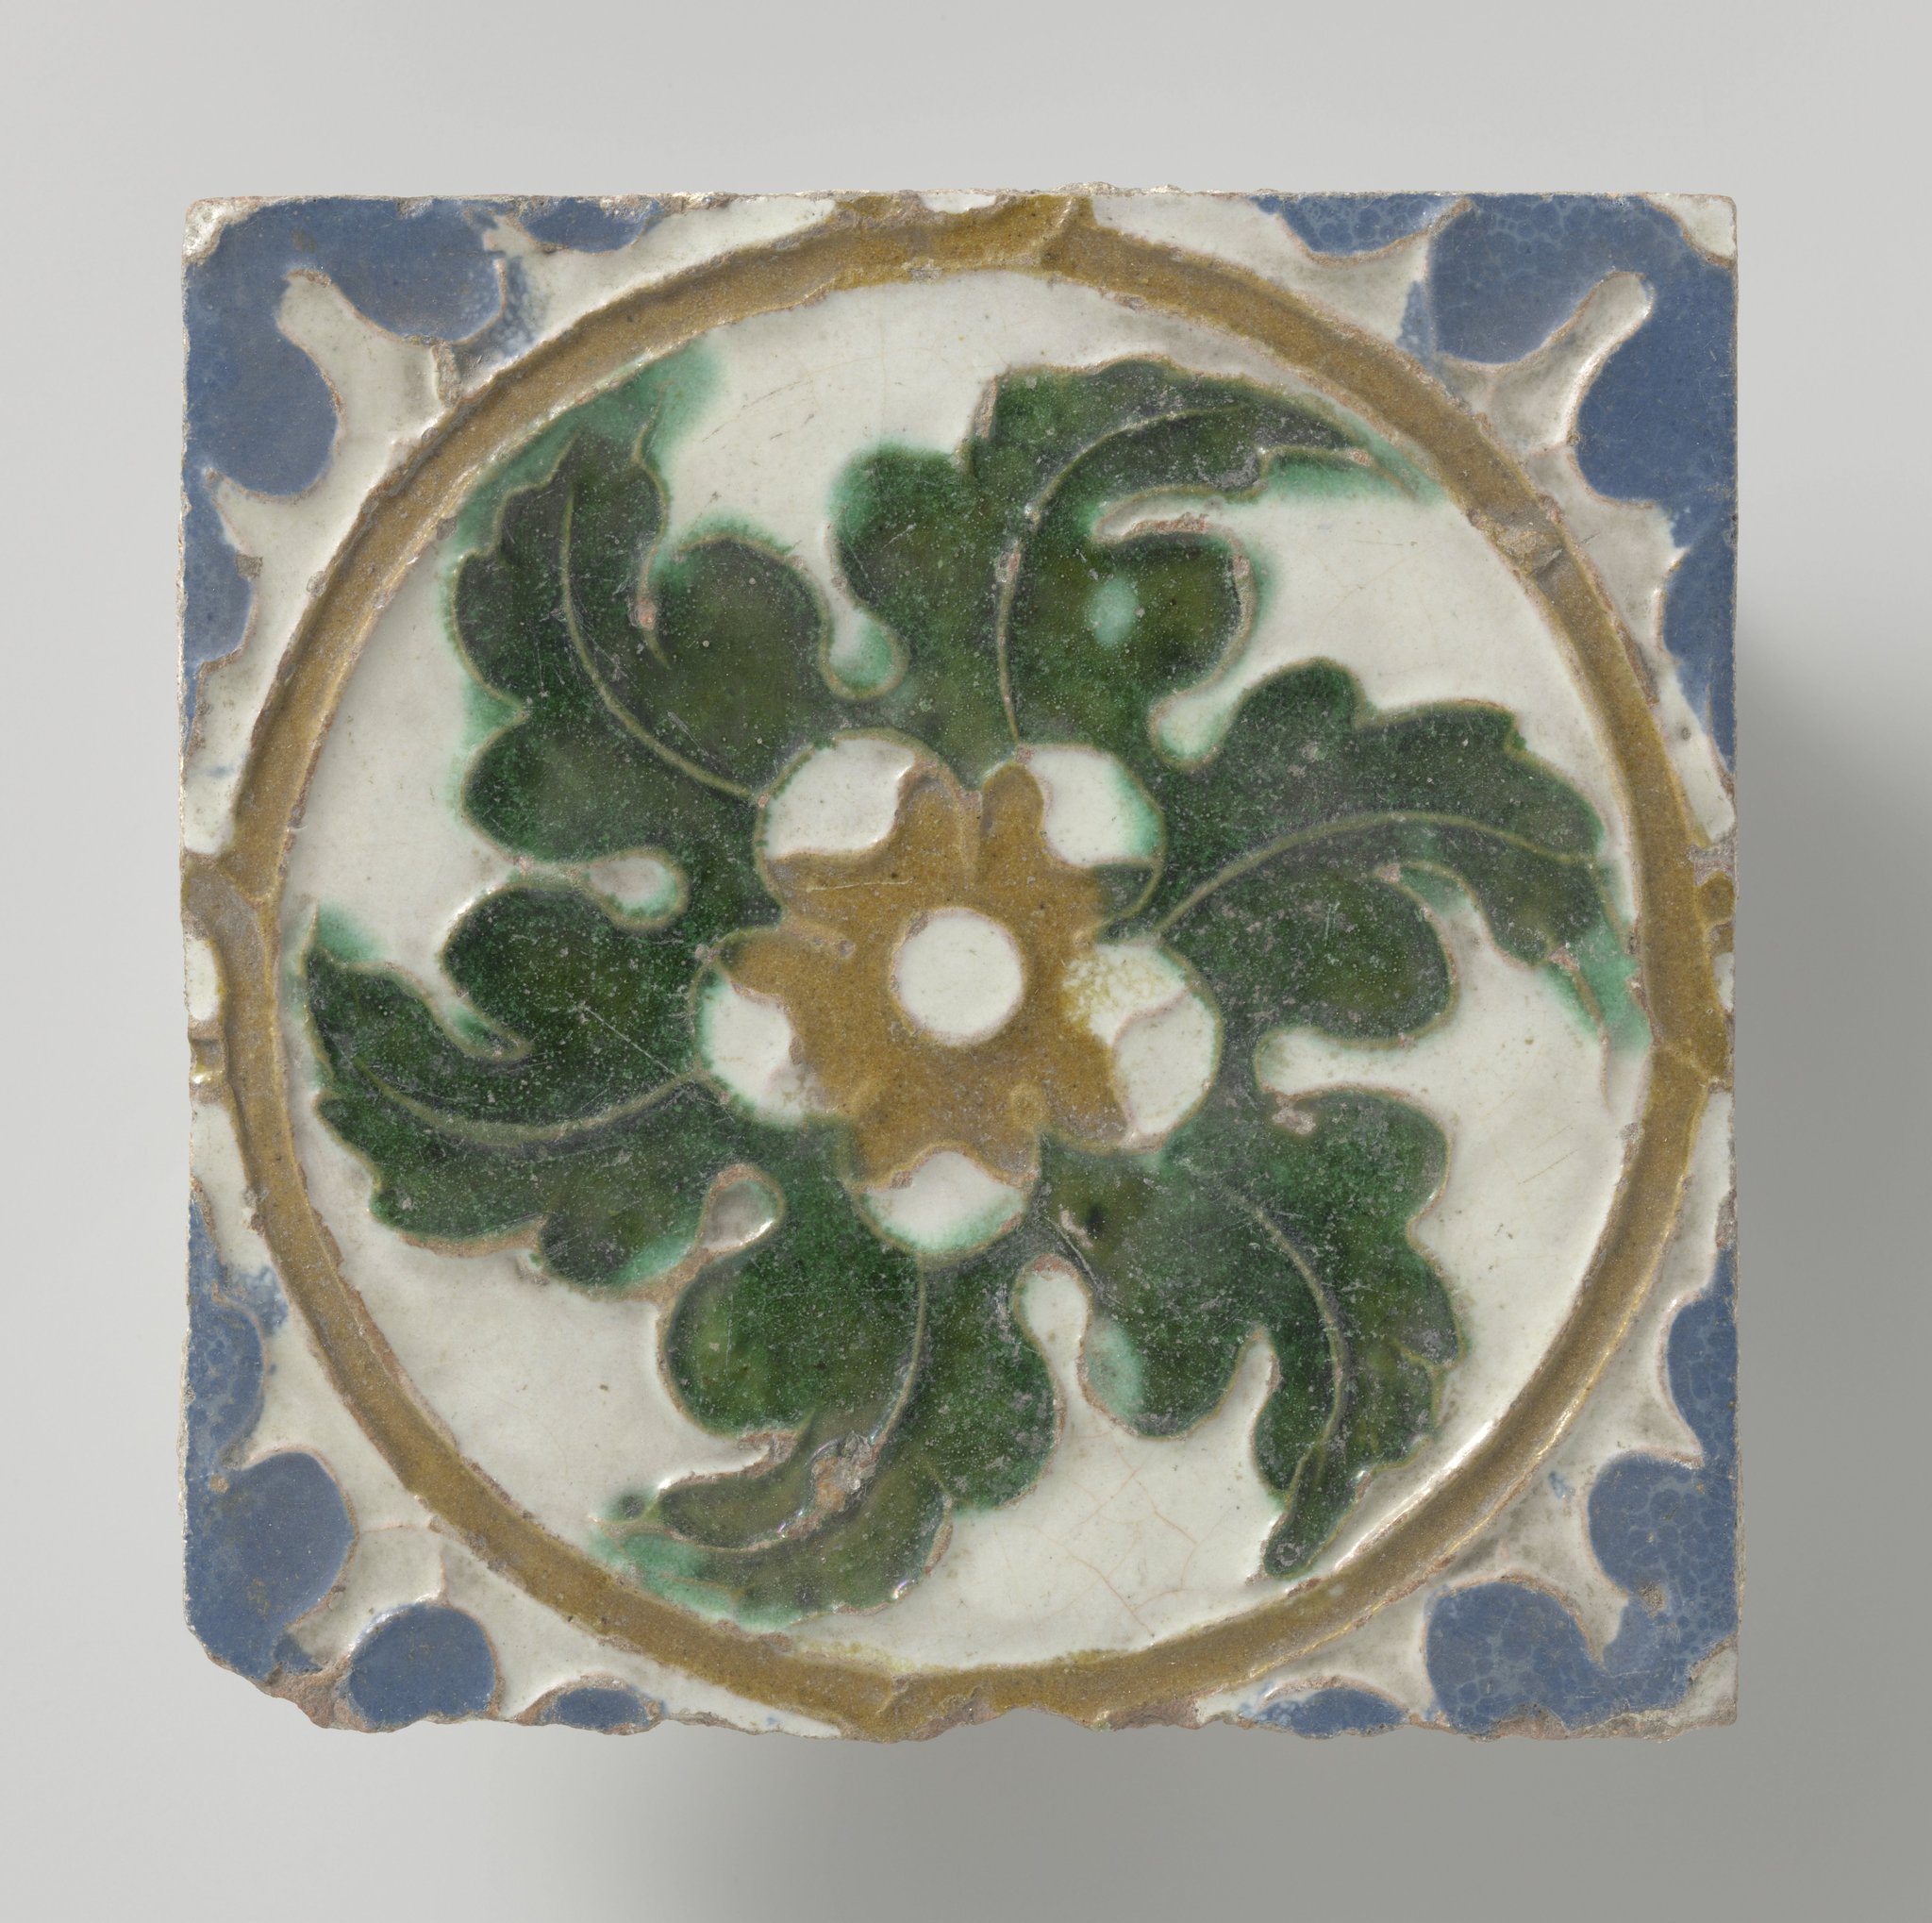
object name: tile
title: Tegel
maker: Anonymous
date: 1500-1600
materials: earthenware, glaze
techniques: lace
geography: spain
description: Cuenca-tegel, beschilderd in wit, groen, geelbruin en blauw. In een cirkel een rozet met uitwaaierende bladeren en een bloemvormig hart. In de hoeken bladdelen.